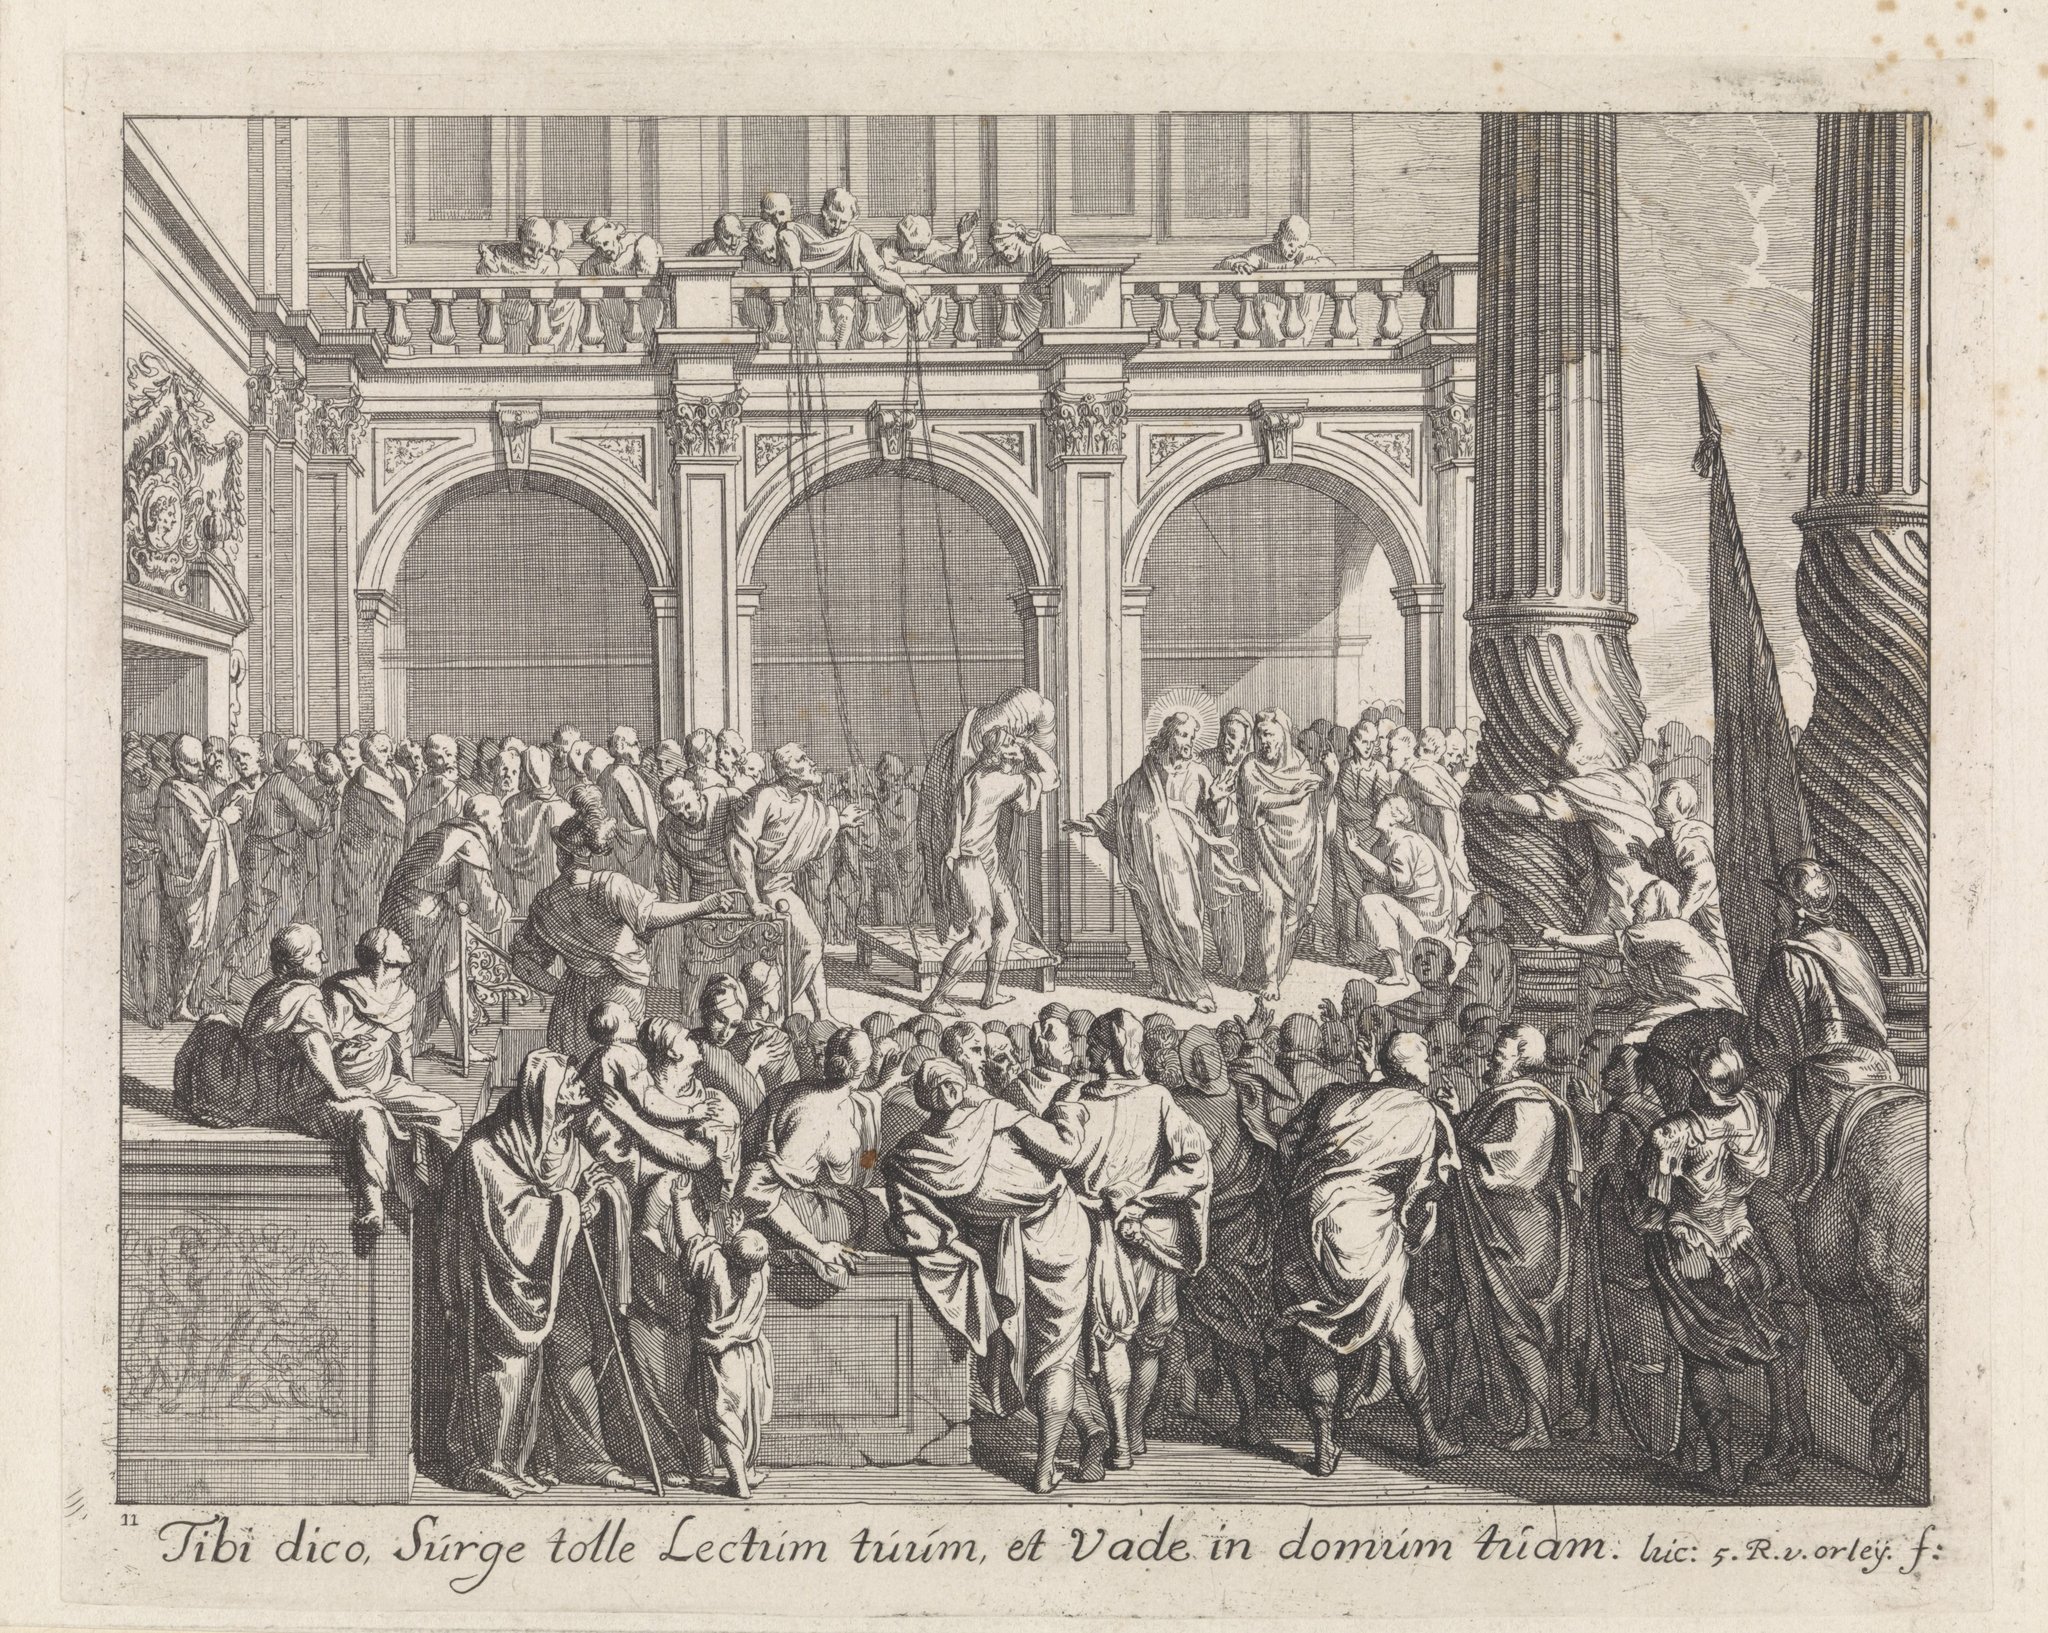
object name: print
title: Scènes uit het Nieuwe Testament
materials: paper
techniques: engraving, etching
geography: brussels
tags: the paralytic takes up his bed and walks away ~ christ healing paralytics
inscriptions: collector's mark: Lugt 240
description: Een verlamde man wordt met zijn bed naar Christus gebracht. Christus staat op de binnenplaats van een gebouw tussen een groep mensen. Hij geneest de man, die opstaat zijn matras oprolt en wegloopt. Onder de afbeelding een Latijns vers uit Luc. 5.